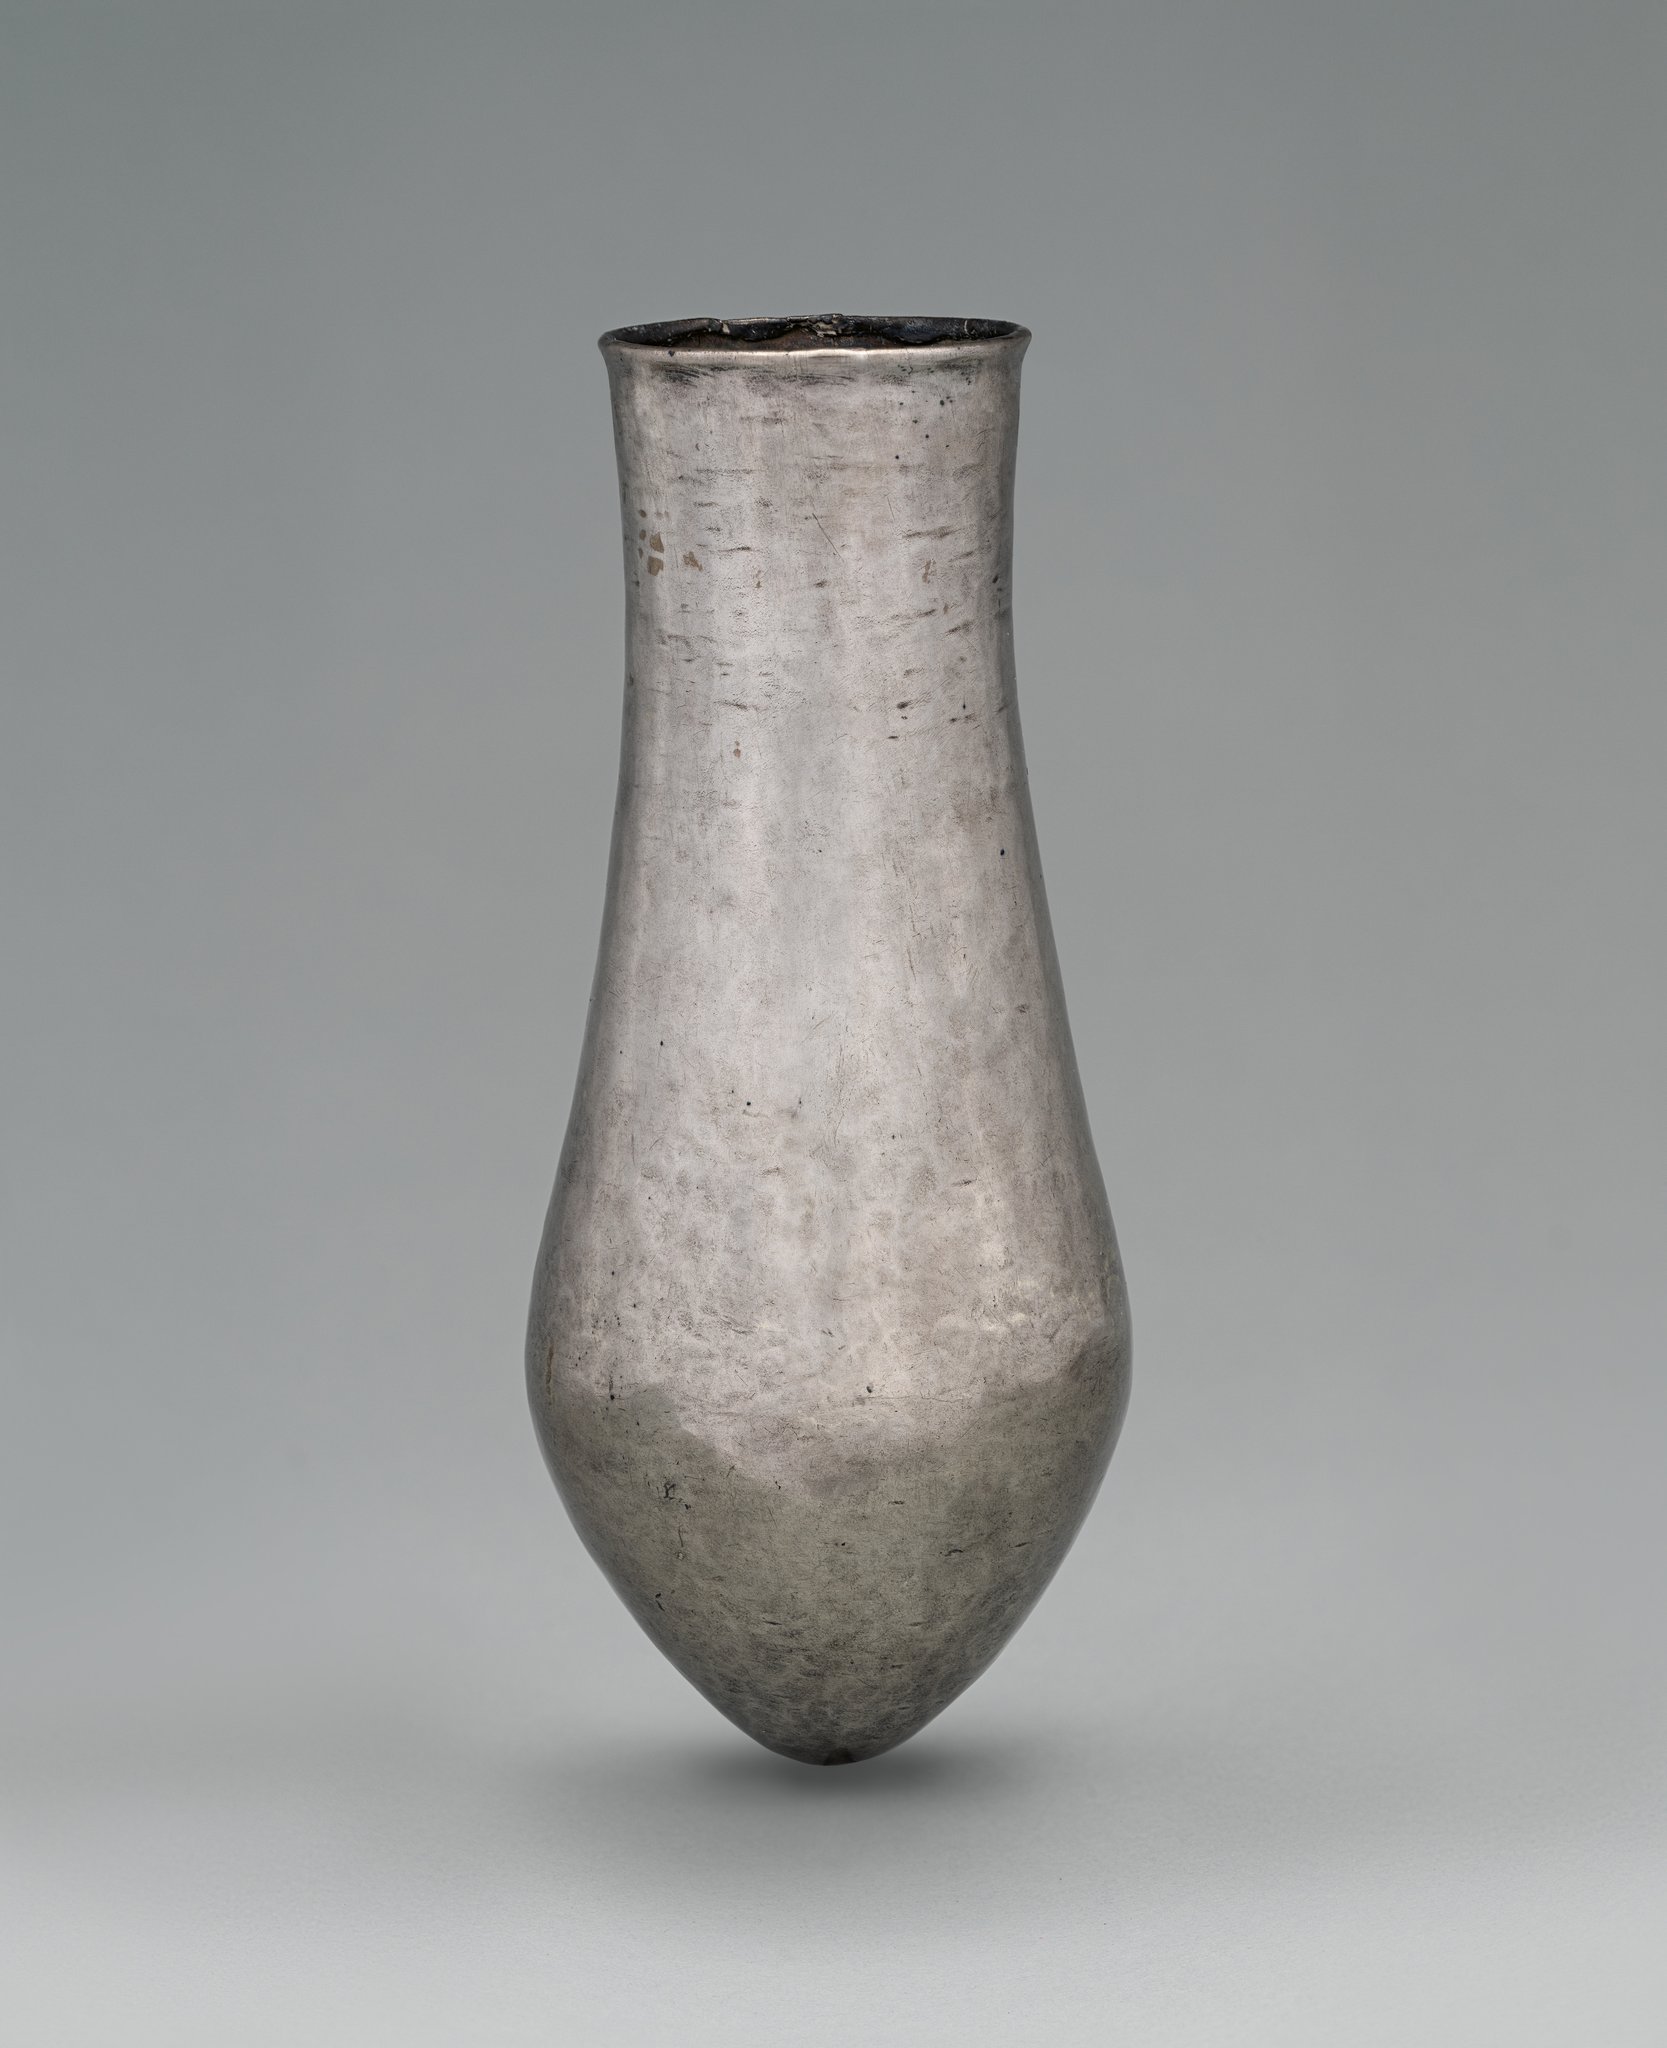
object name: situla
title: Situla with plain rim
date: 1279-1213 BCE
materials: silver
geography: egypt